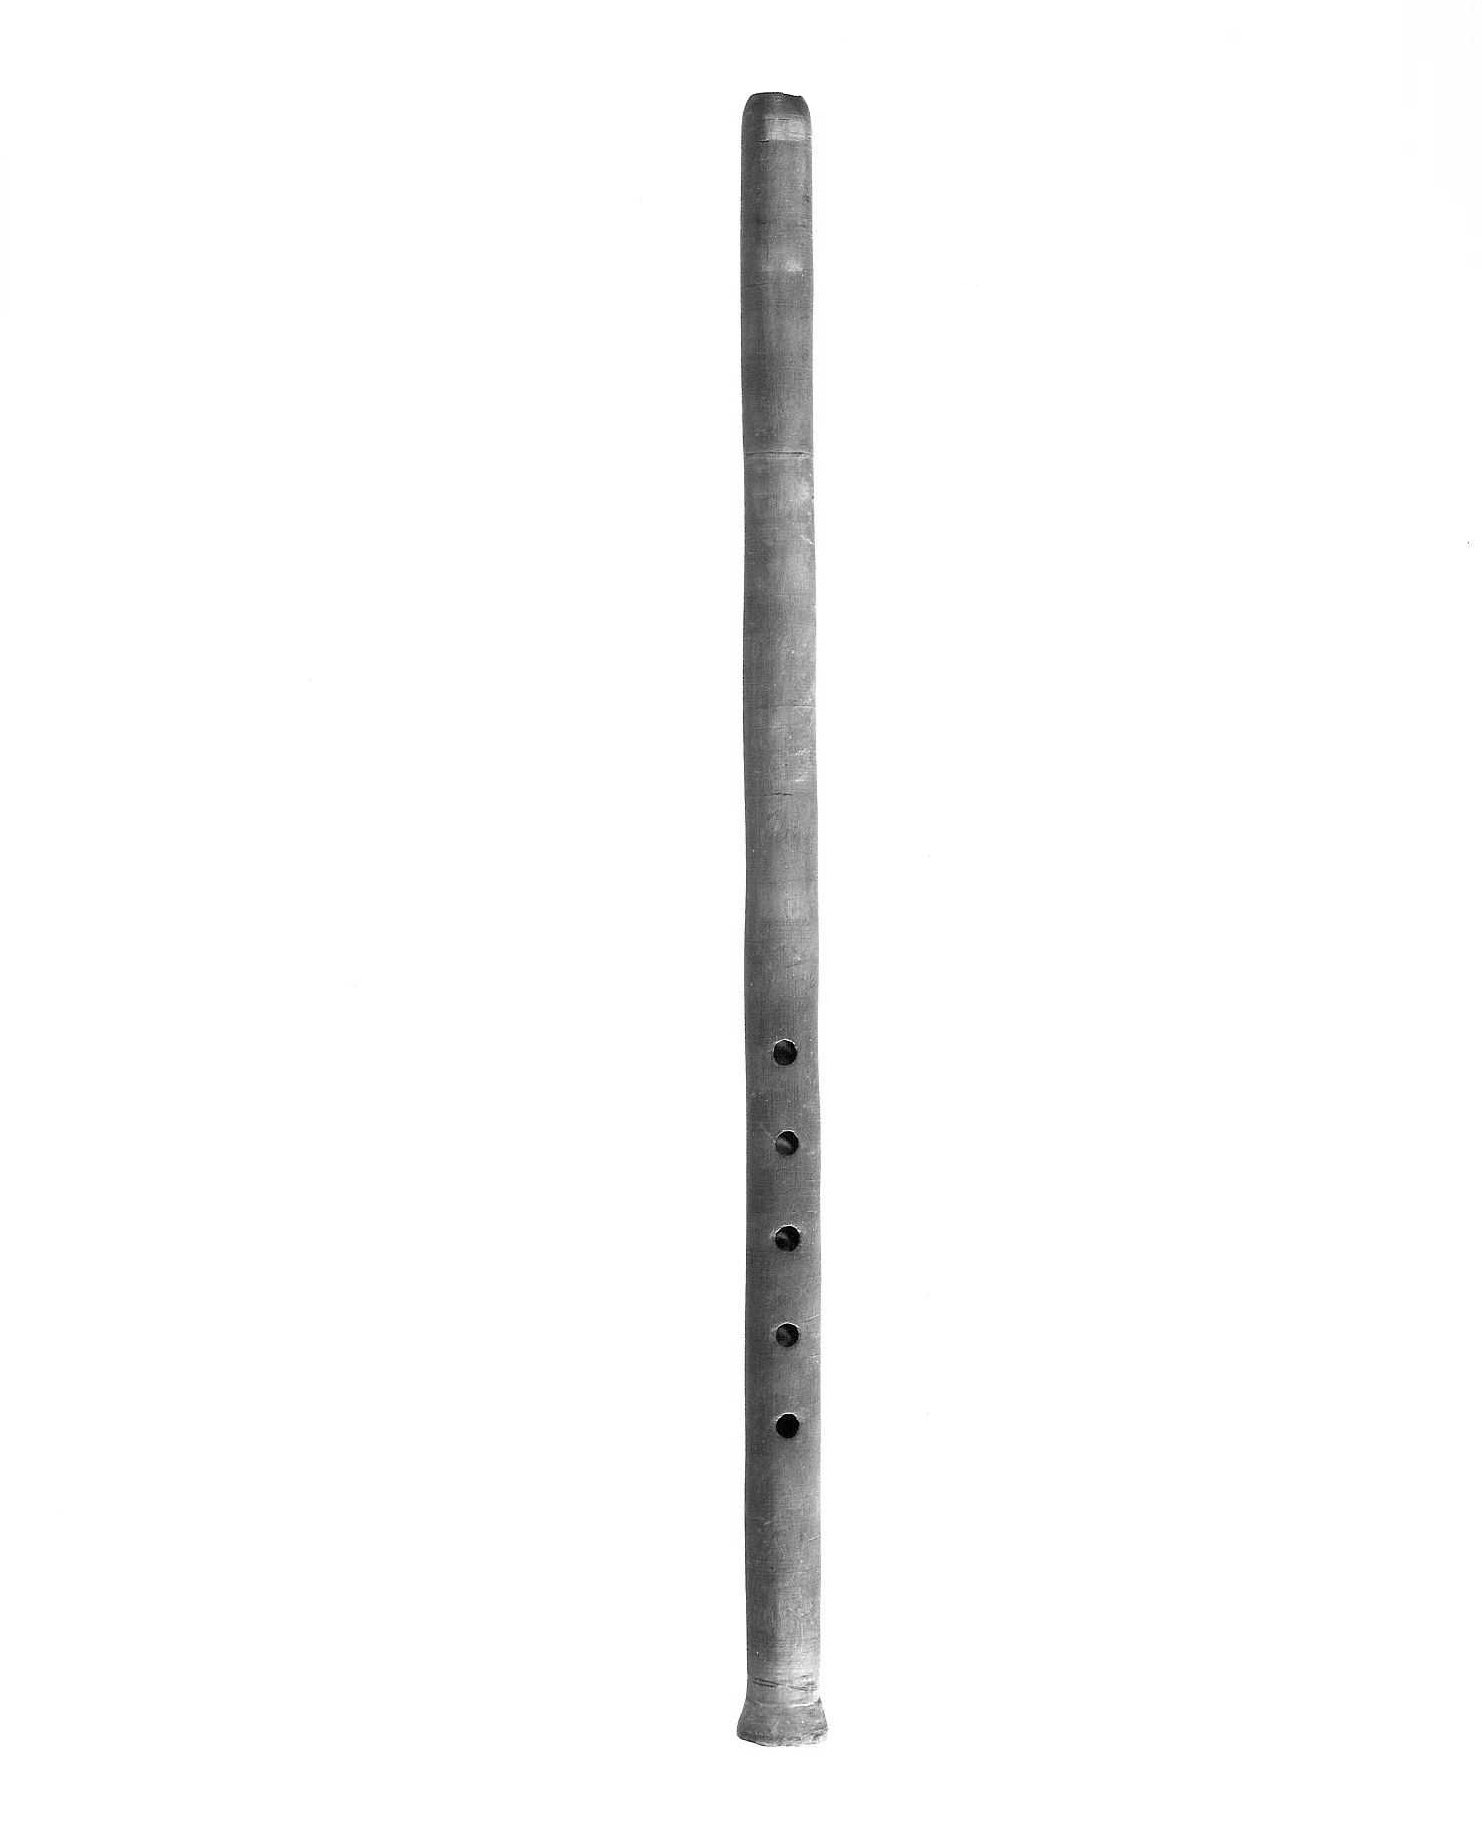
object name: kaval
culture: romanian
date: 1867-1900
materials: wood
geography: romania